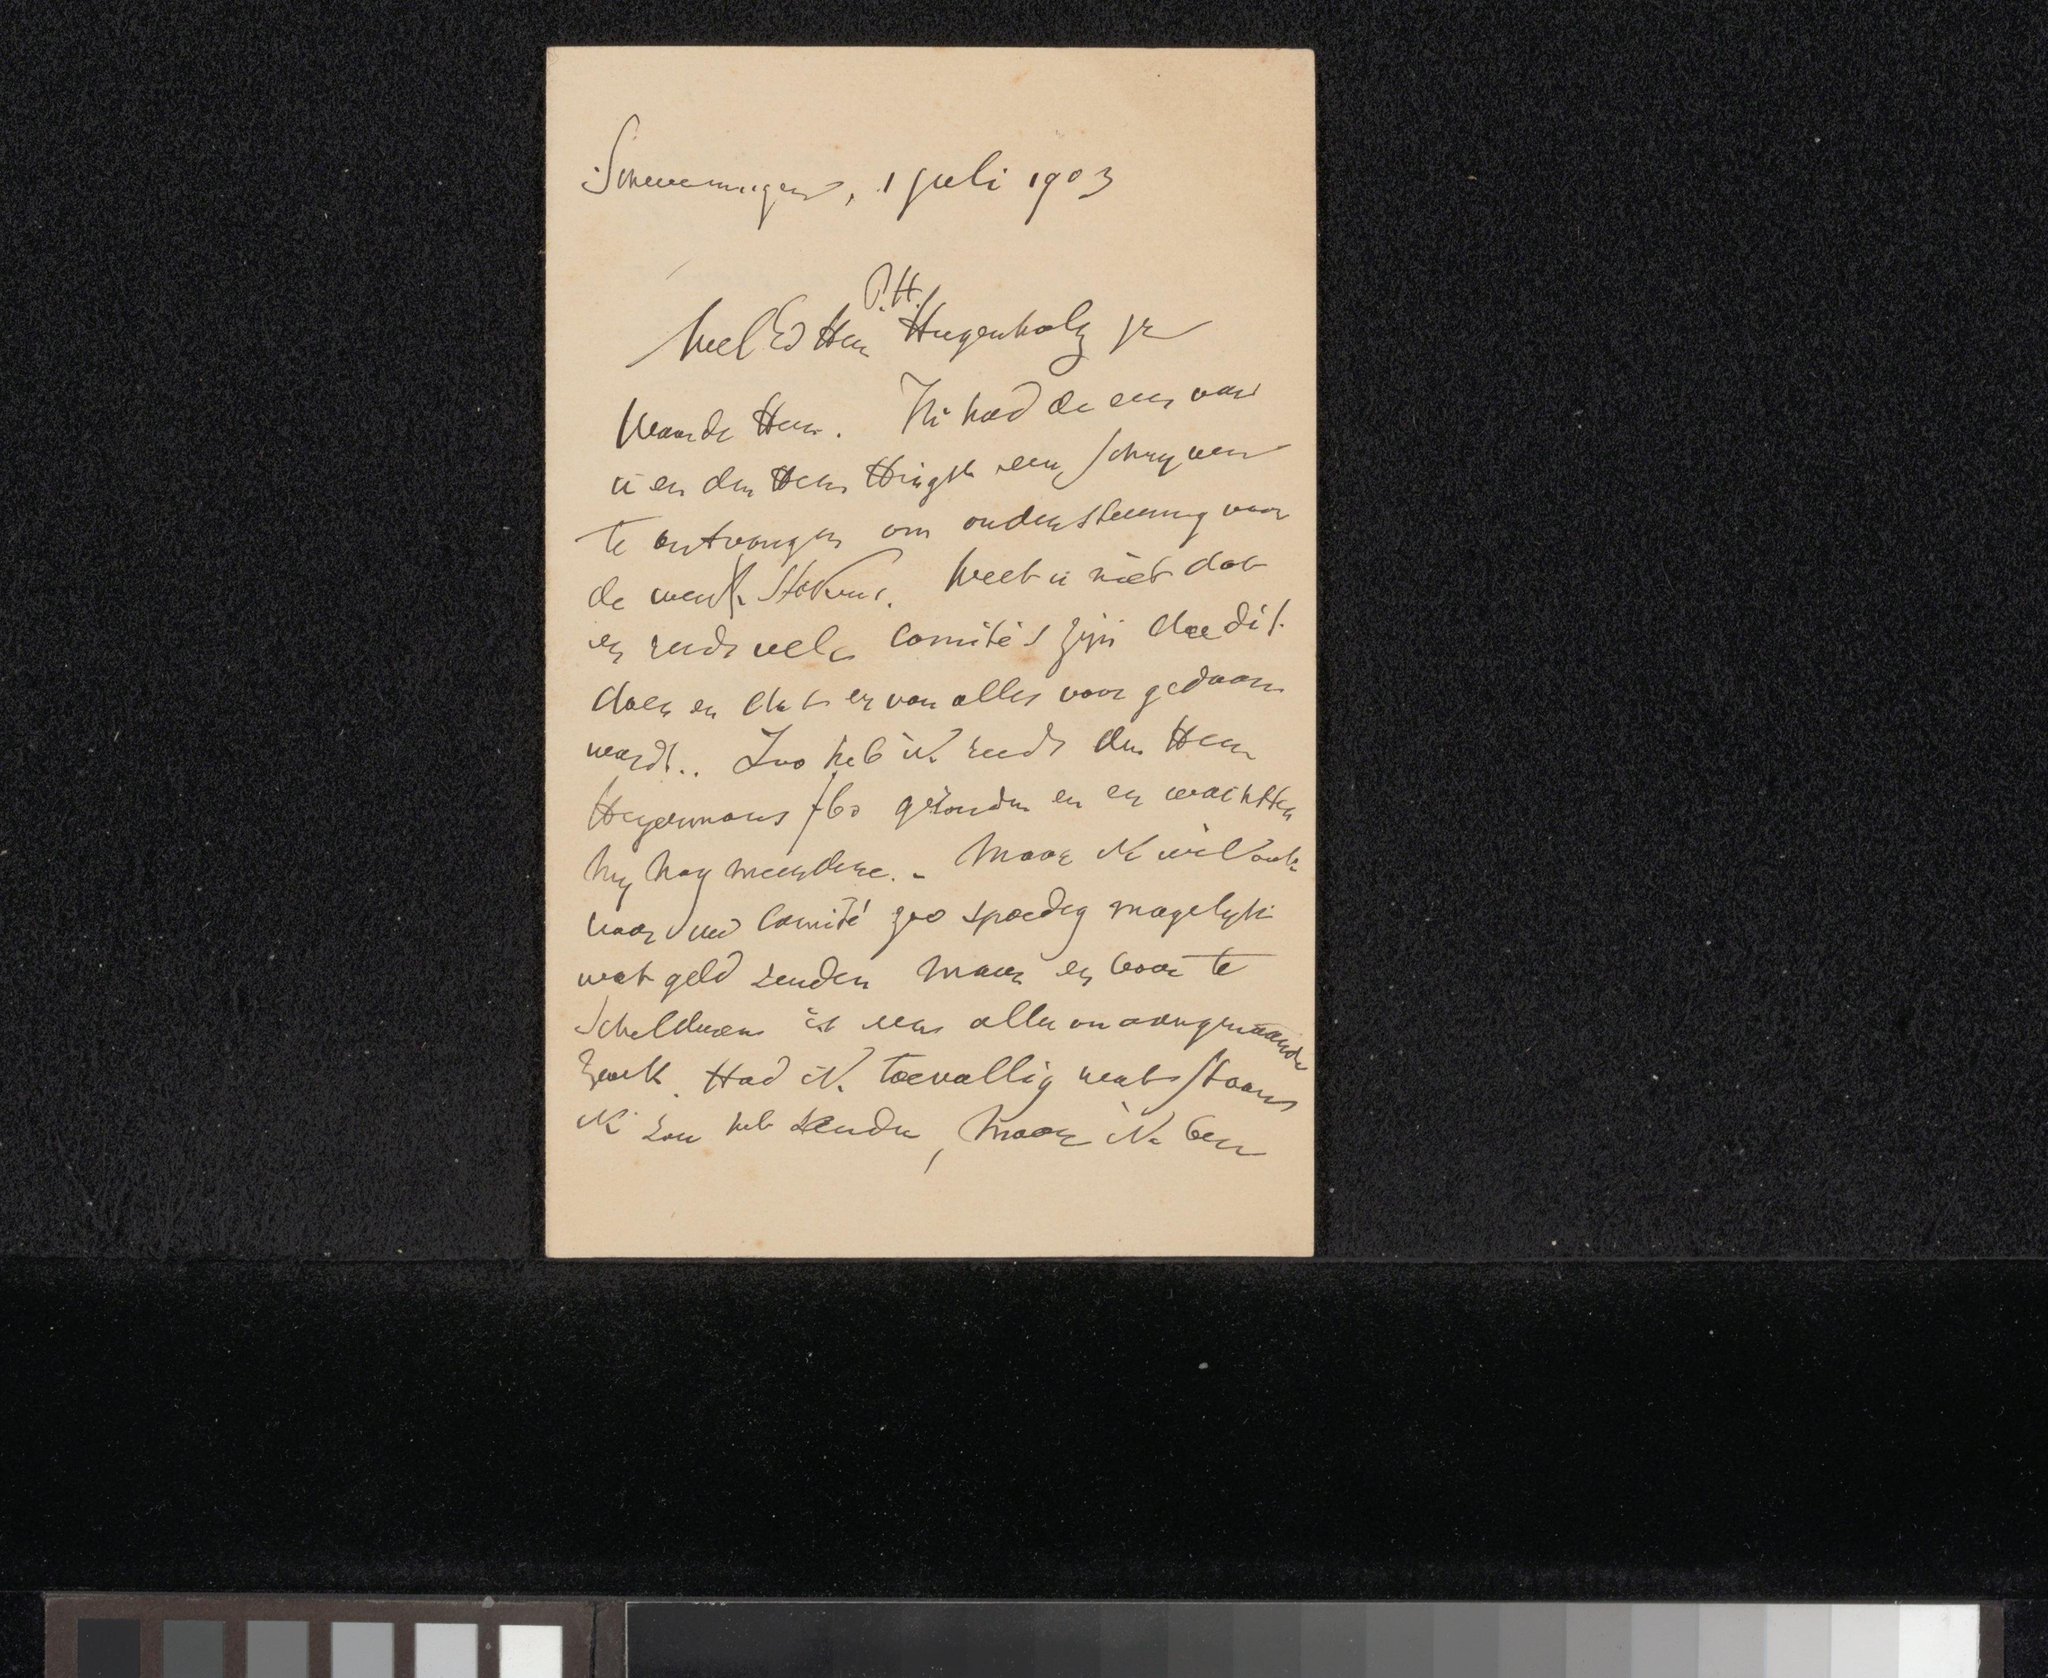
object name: letter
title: Brief aan Petrus Hermannus Hugenholtz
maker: jozef israëls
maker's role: draughtsman, painter, print maker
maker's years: 1824-1911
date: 1903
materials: ink, paper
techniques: pen, writing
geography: scheveningen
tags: the hague, painter, draughtsman, philip zilcken, painting (including book-illumination, miniature-painting), money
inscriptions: watermark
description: Bij de brief wordt een reproductie van een brief van Jozef Israels aan Philip Zilcken (zie RP-D-1982-43-ISRAËLS(JOZEF)-78A) bewaard.